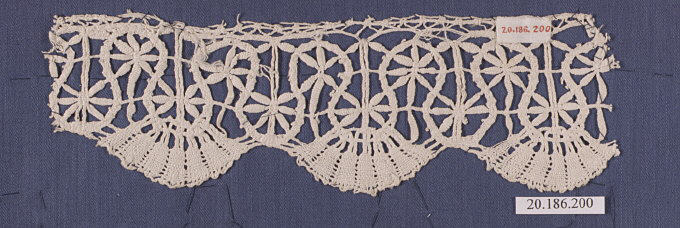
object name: edging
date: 1601-1700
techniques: lace